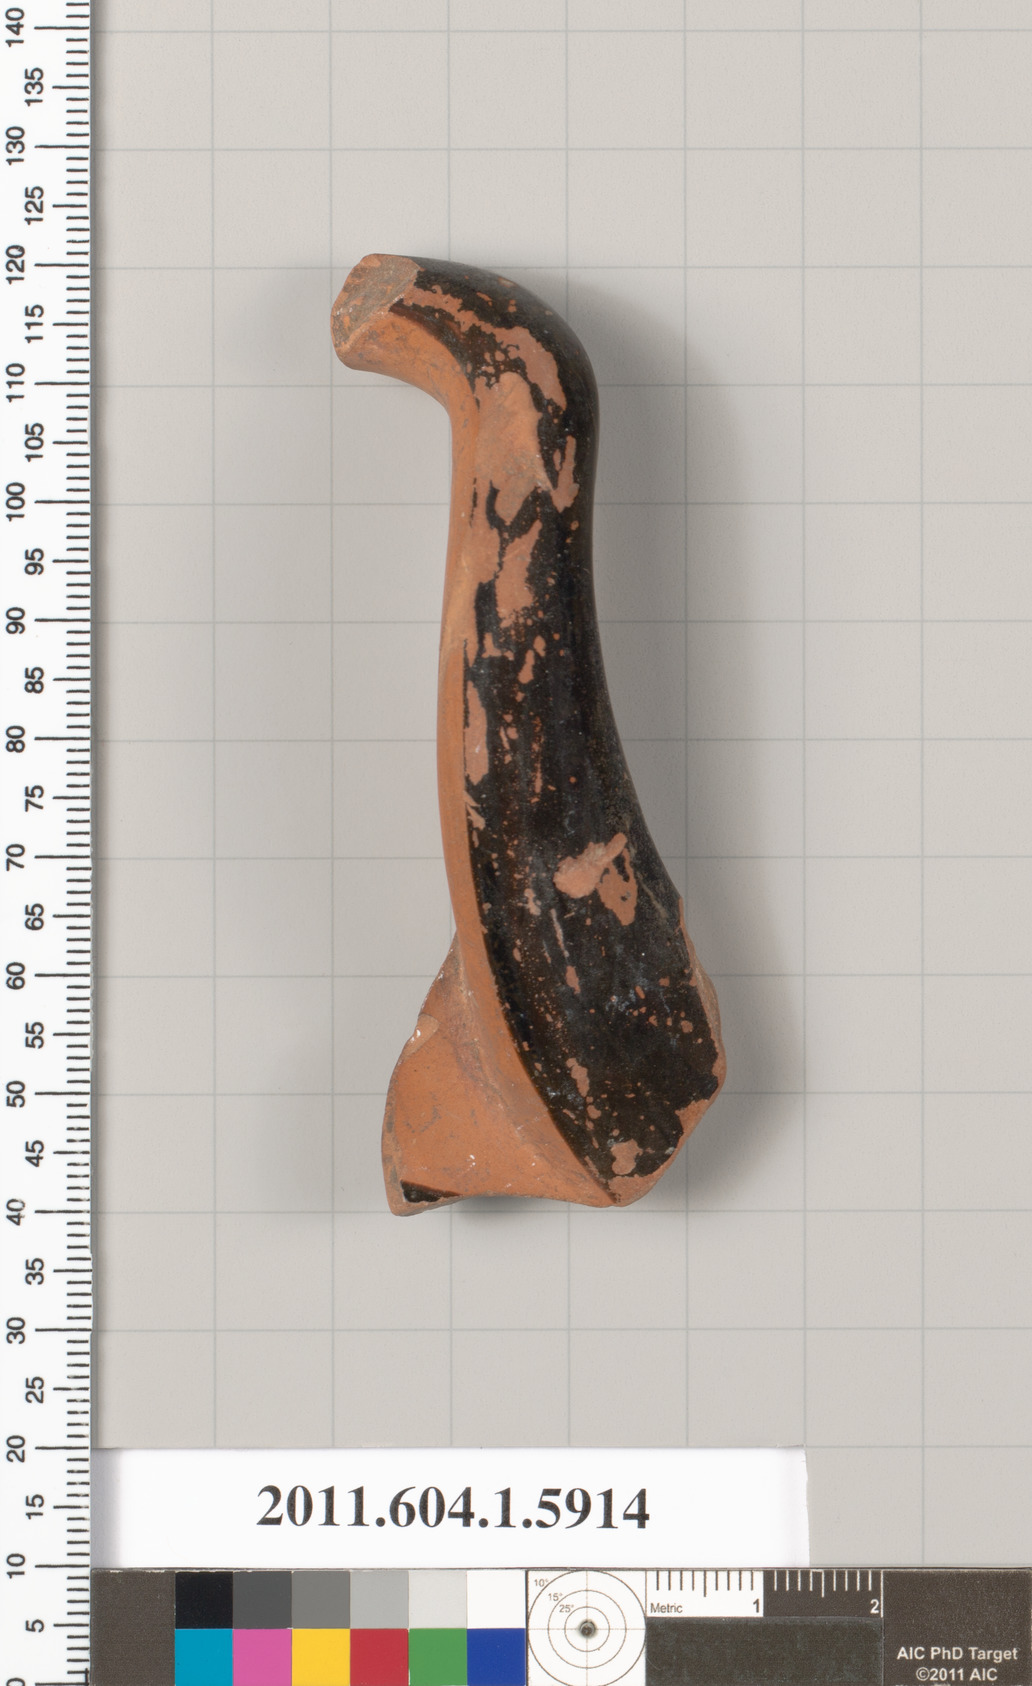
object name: kylix fragment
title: Terracotta fragment of a kylix (drinking cup)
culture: greek, attic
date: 520-510 BCE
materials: terracotta